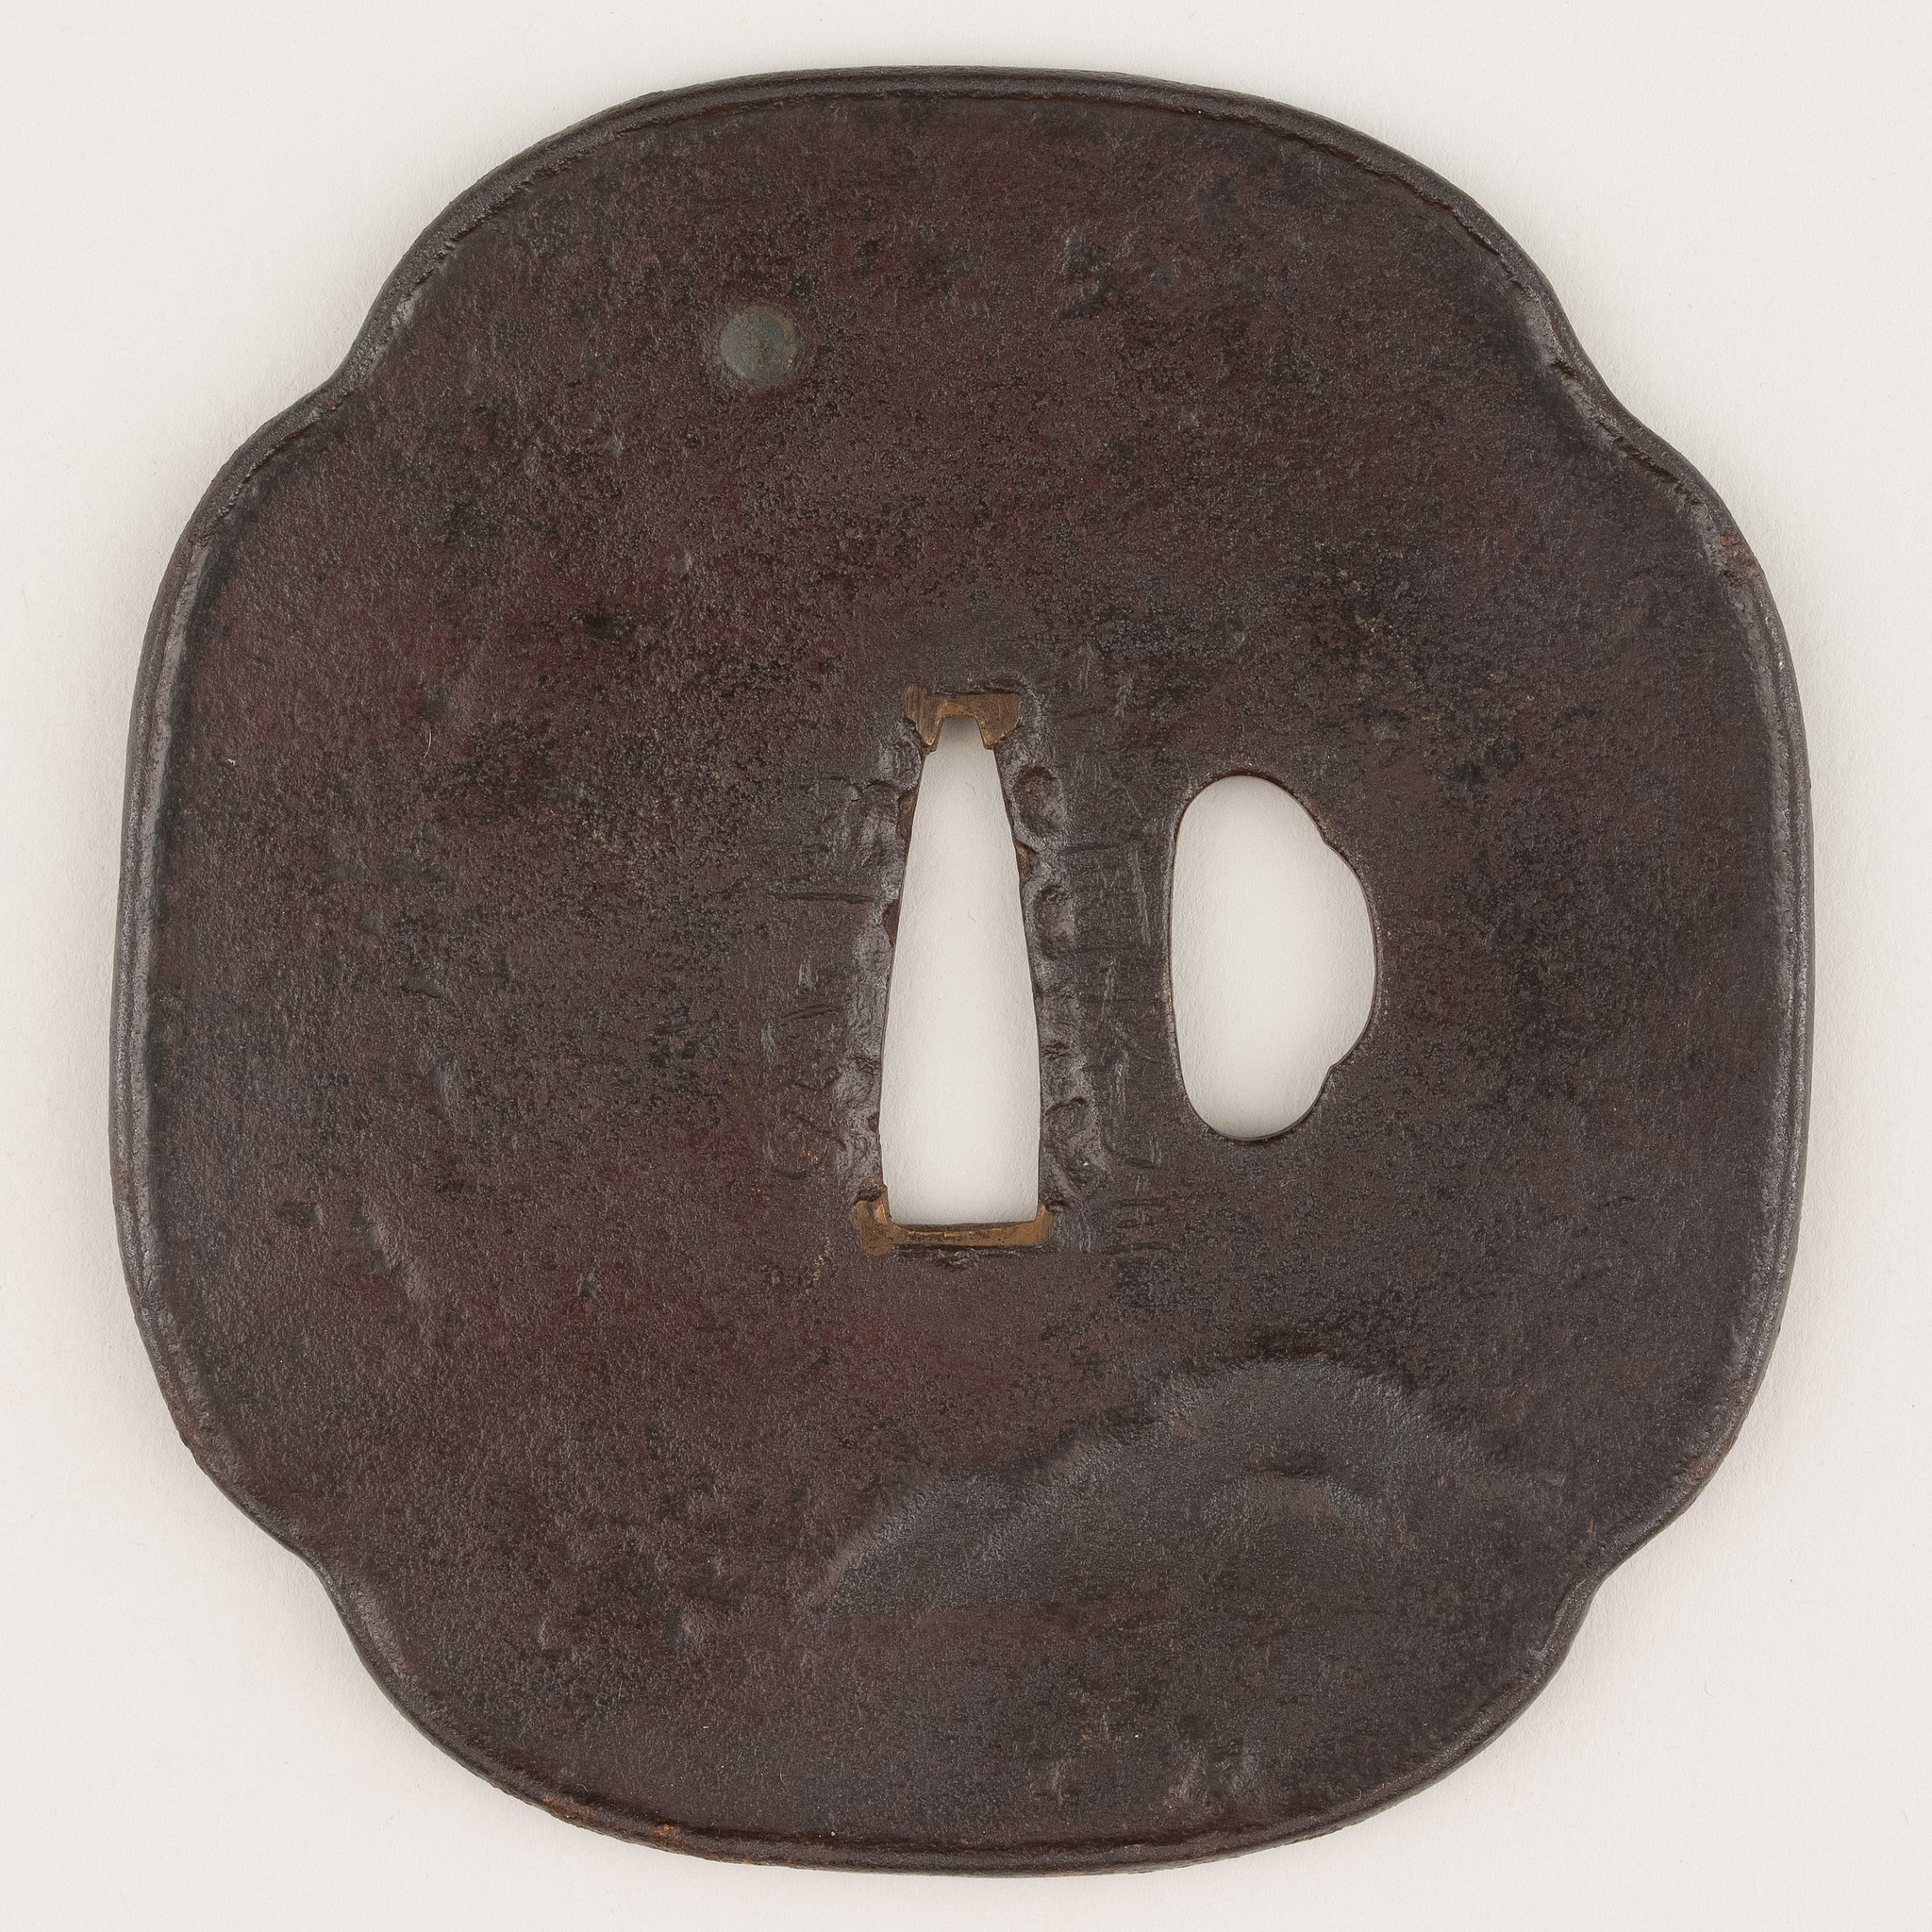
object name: sword guard tsuba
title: Sword Guard (Tsuba)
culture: japanese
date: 1601-1800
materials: iron, silver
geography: japan